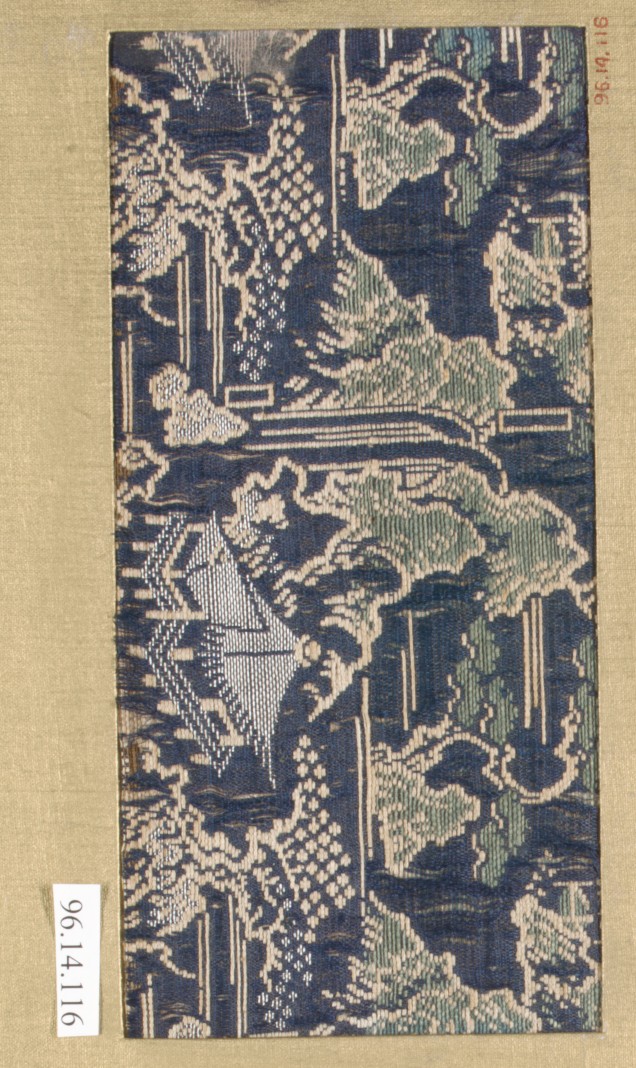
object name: piece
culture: japanese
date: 1701-1900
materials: silk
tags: landscapes